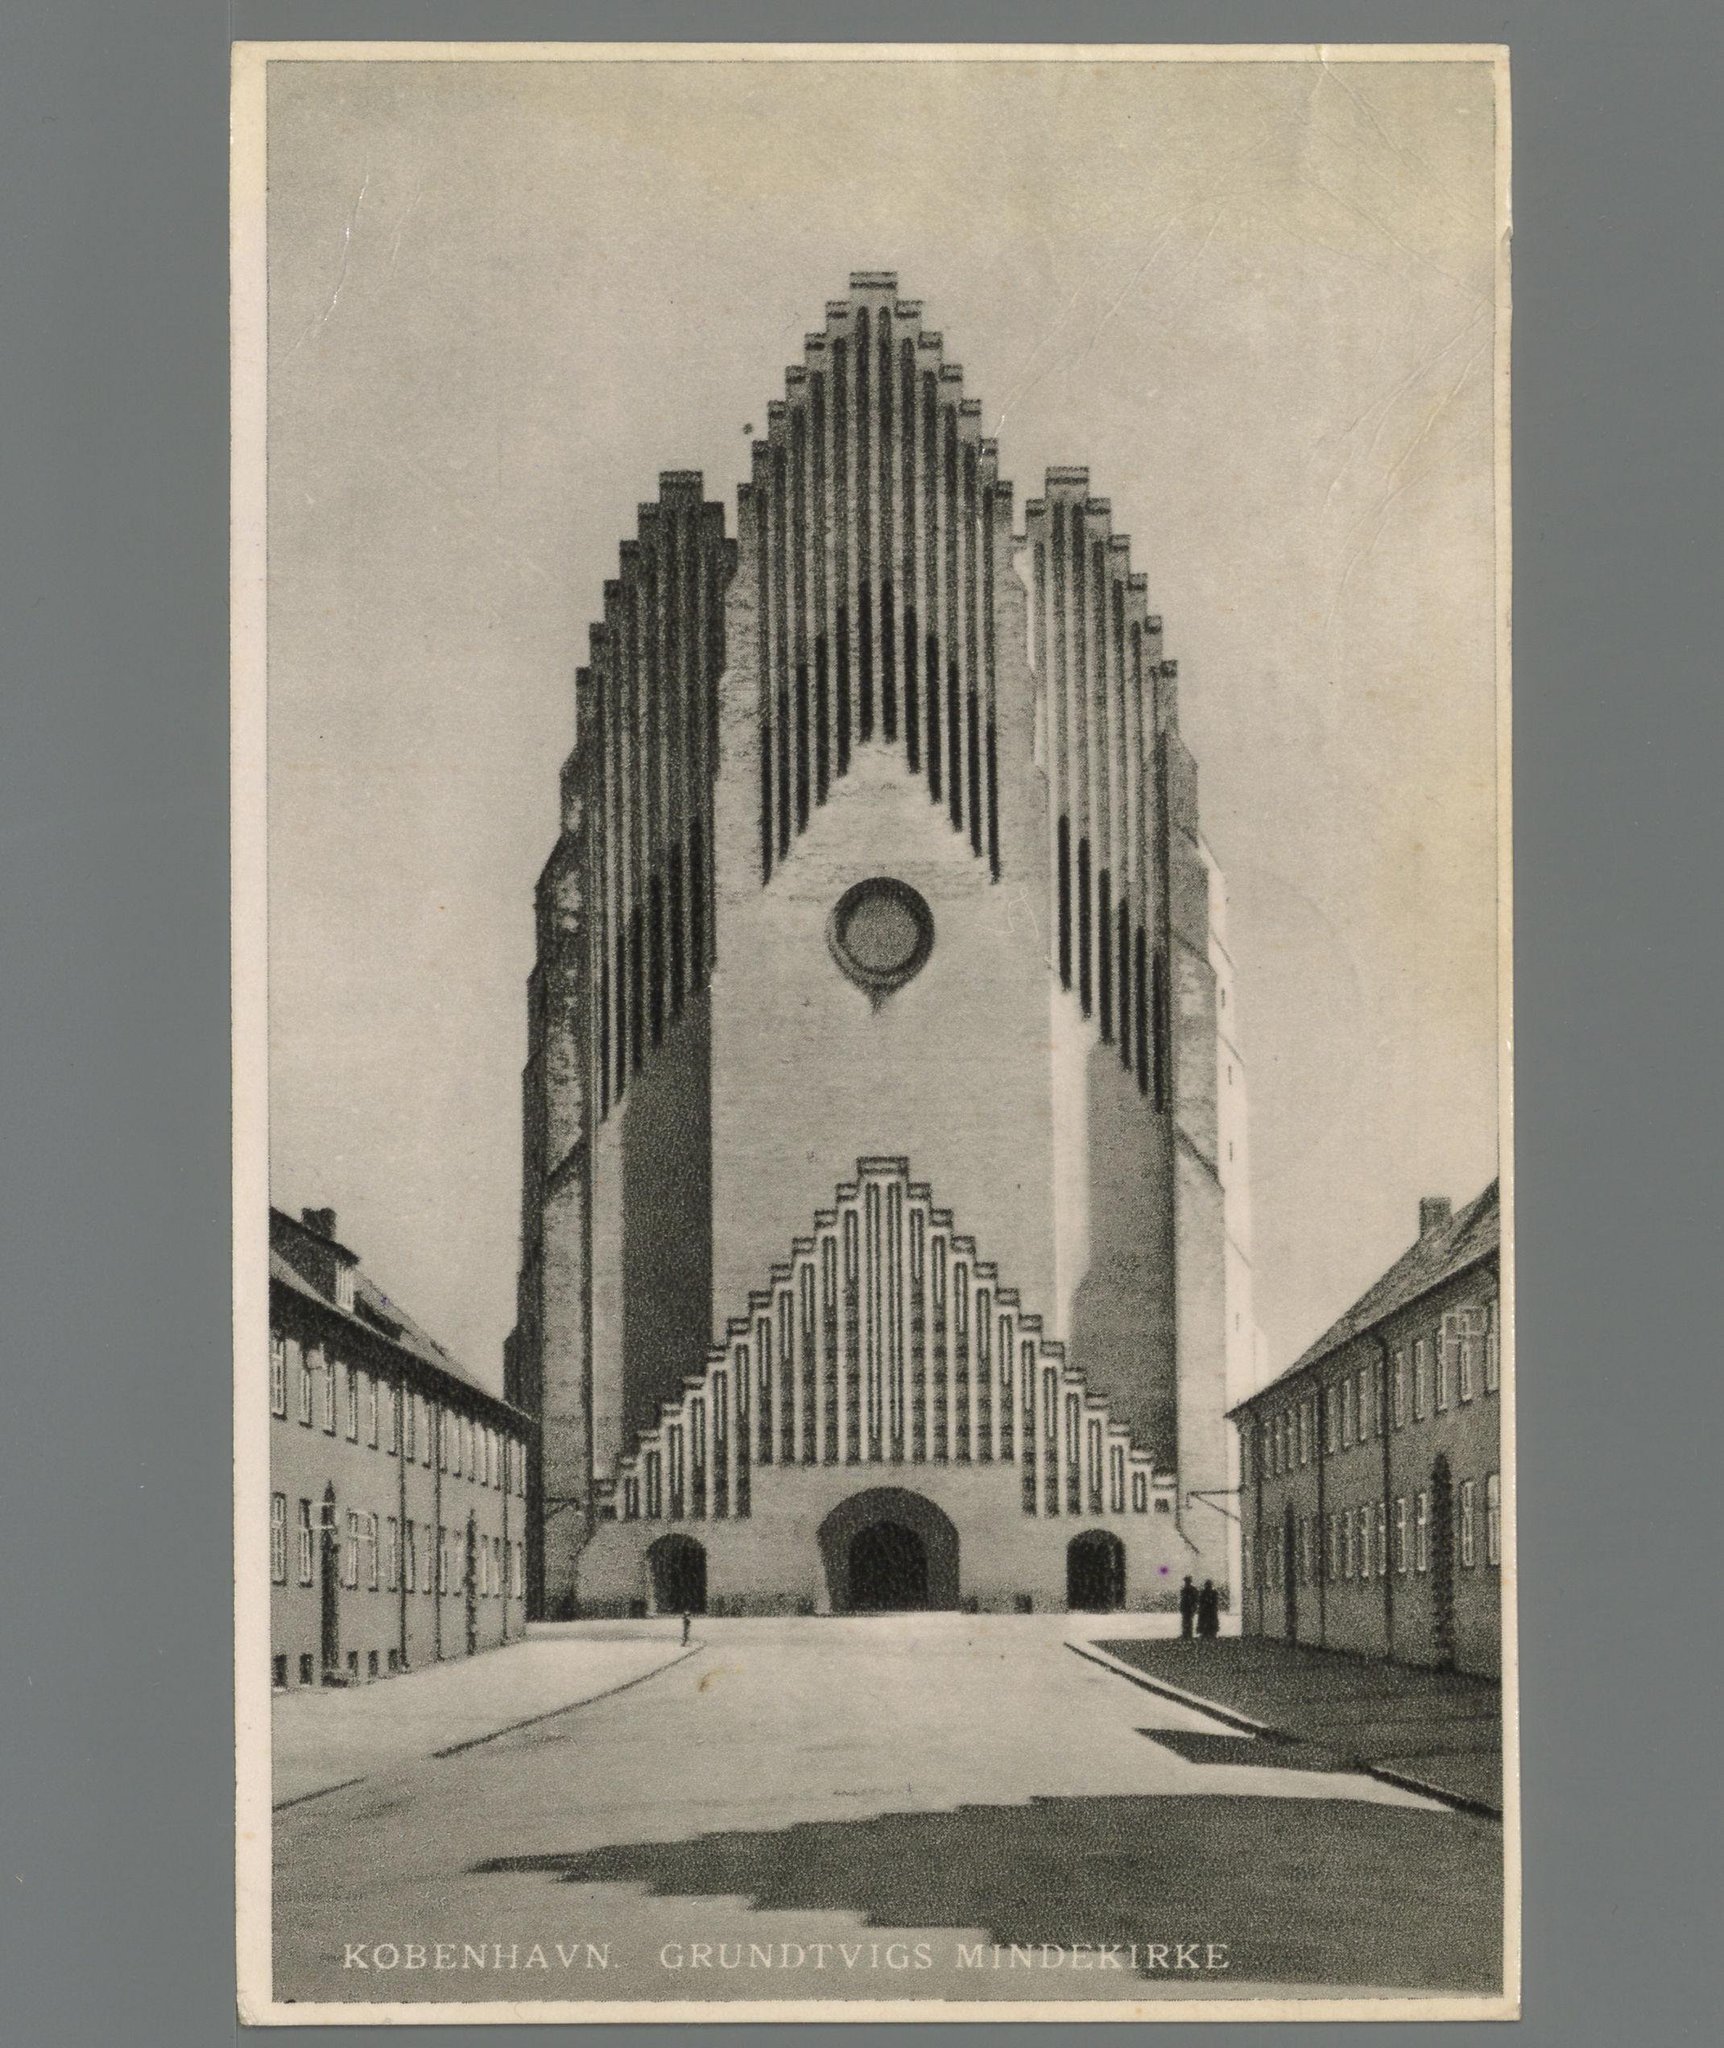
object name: photograph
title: København. Grundtvigs Mindekirke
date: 1921-1936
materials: photographic support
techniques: photography, writing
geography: copenhagen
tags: church (exterior)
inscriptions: inscription: ‘JCO’